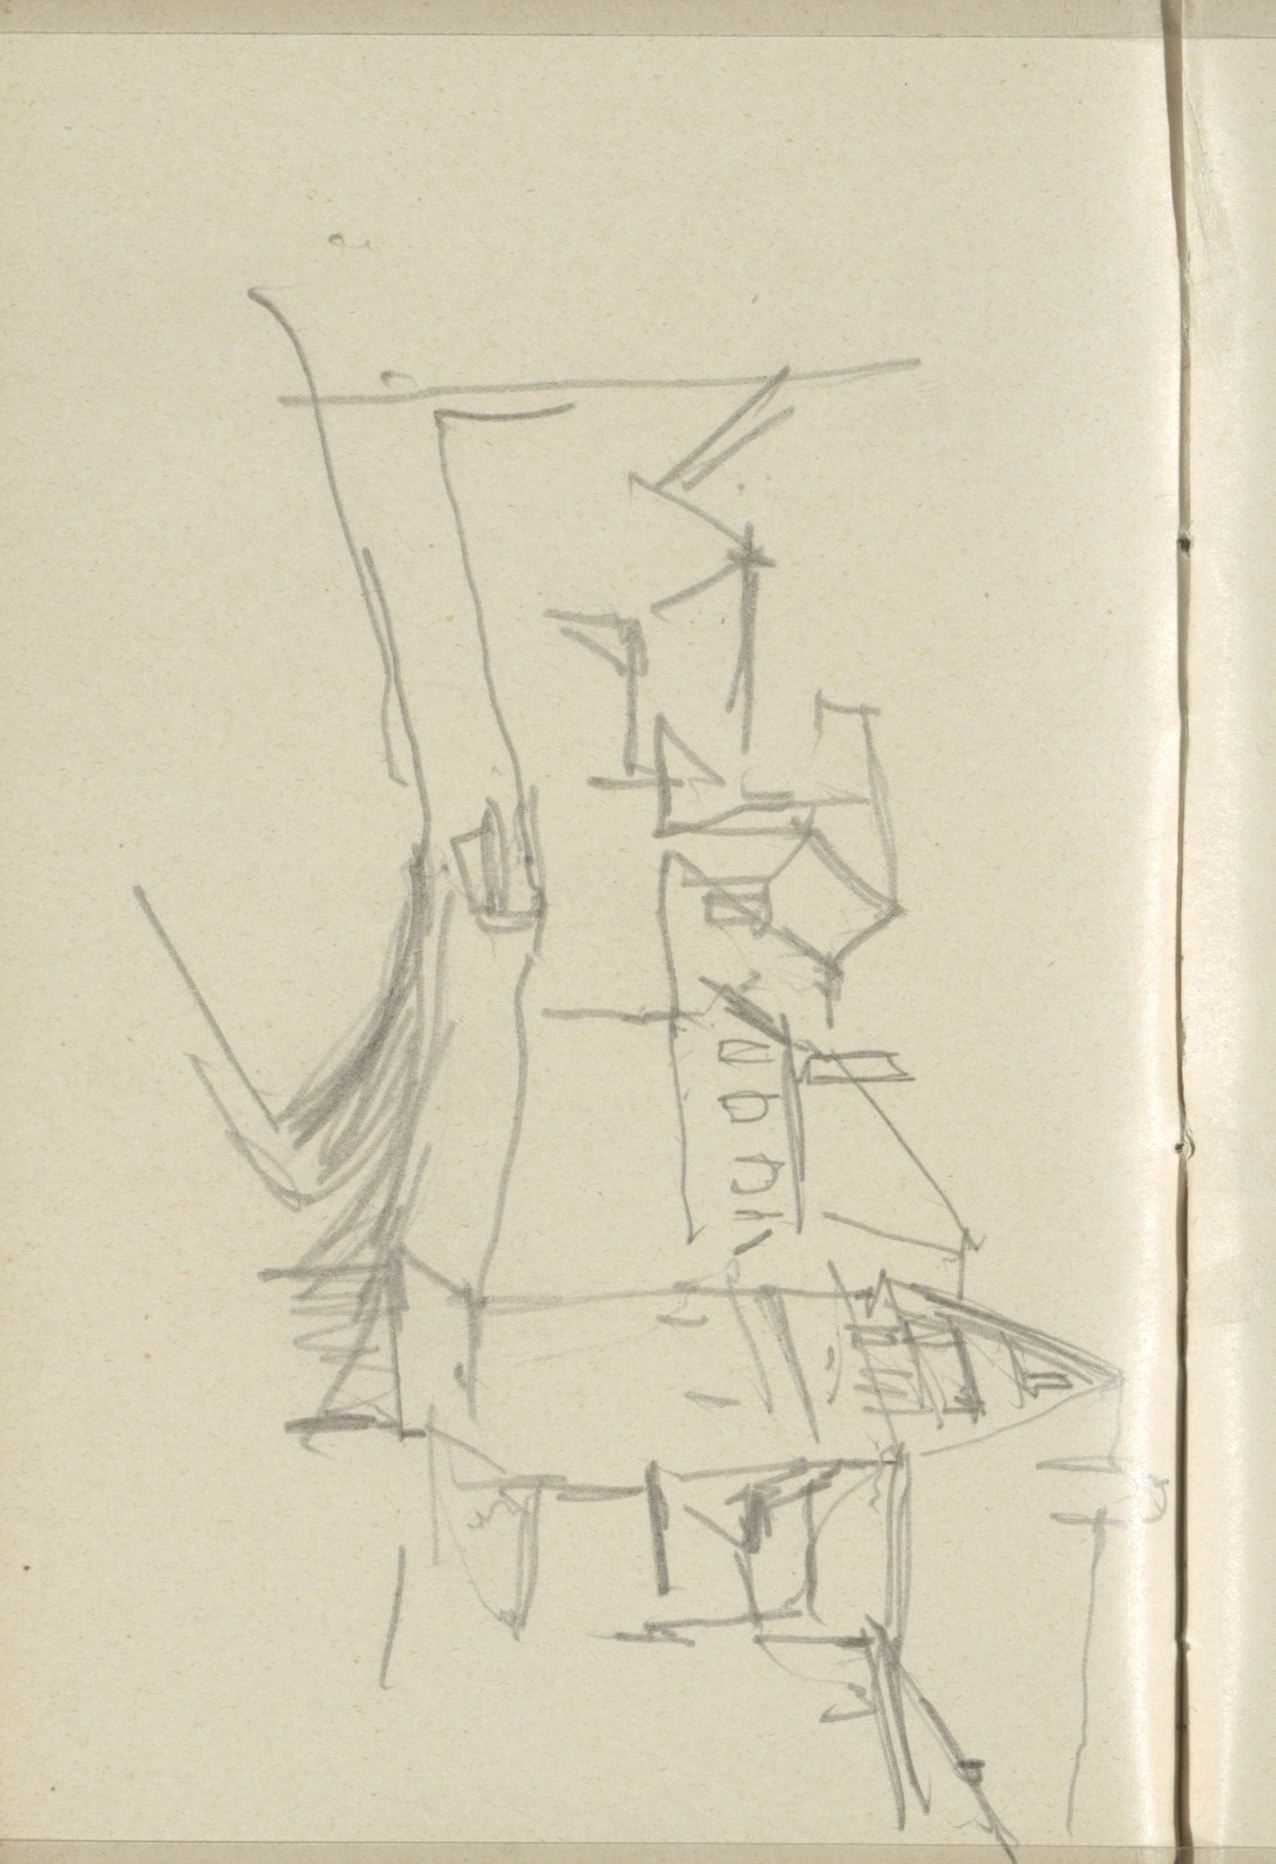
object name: sketchbook leaf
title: Stadsgezicht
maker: george hendrik breitner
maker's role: draughtsman, painter, print maker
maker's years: 1857-1923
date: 1915-1916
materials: paper, pencil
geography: netherlands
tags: city-view, and landscape with man-made constructions, civic architecture; edifices; dwellings, street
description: Pagina 75 uit een schetsboek met 43 bladen.